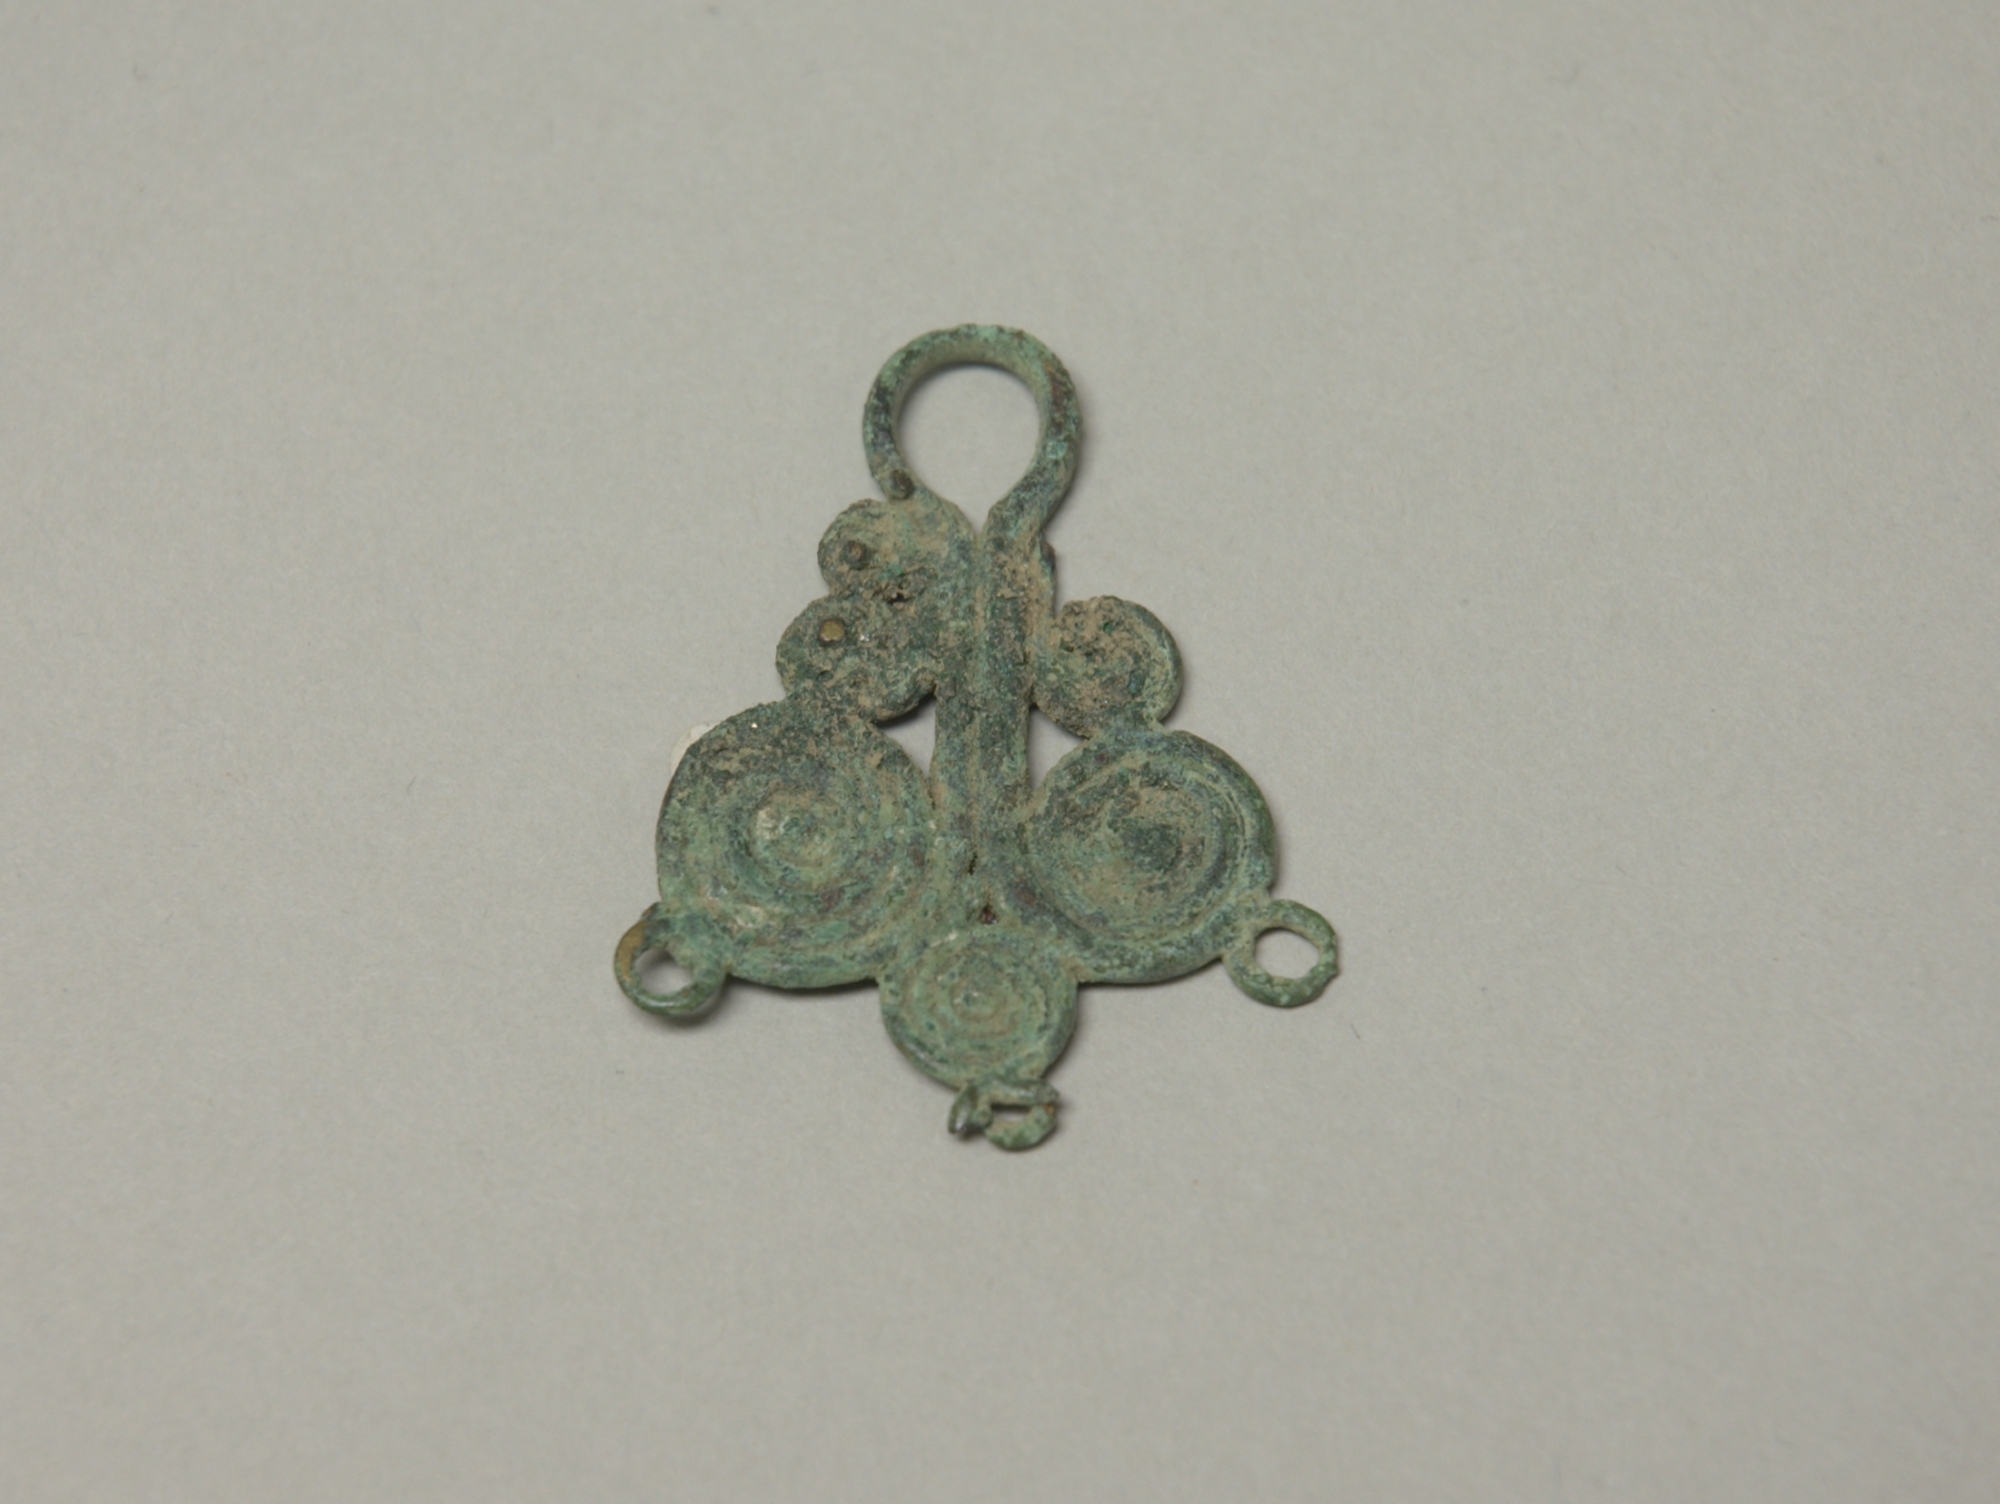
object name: pendant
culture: indonesian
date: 500 BCE-300 CE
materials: bronze